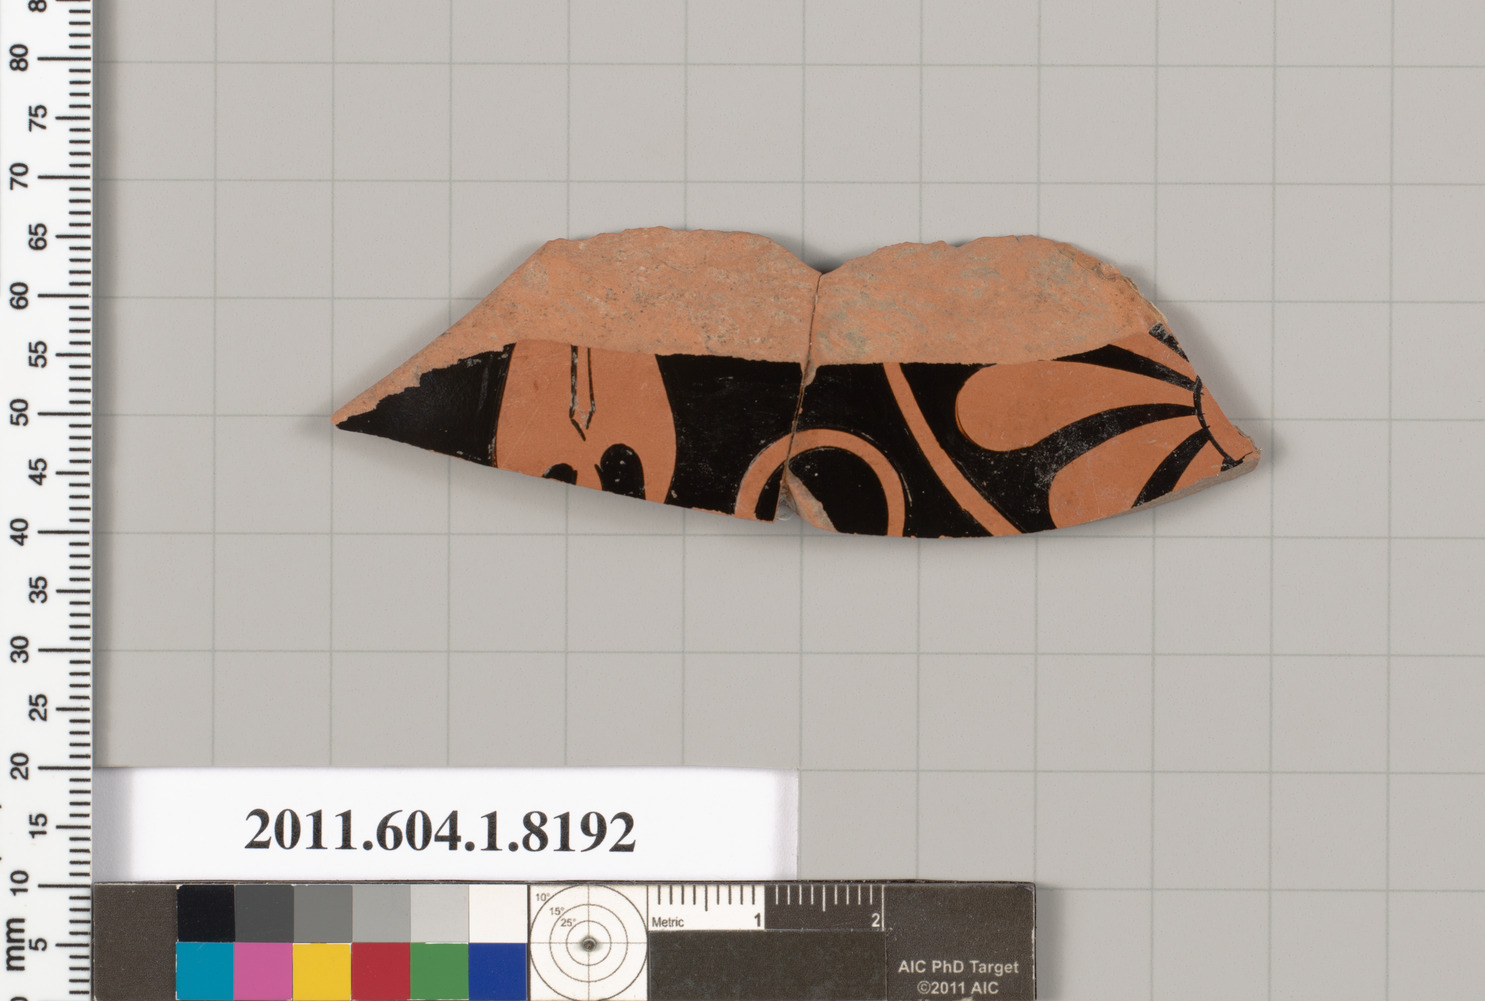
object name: kylix fragment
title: Terracotta fragment of a kylix (drinking cup)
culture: greek, attic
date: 520-510 BCE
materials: terracotta